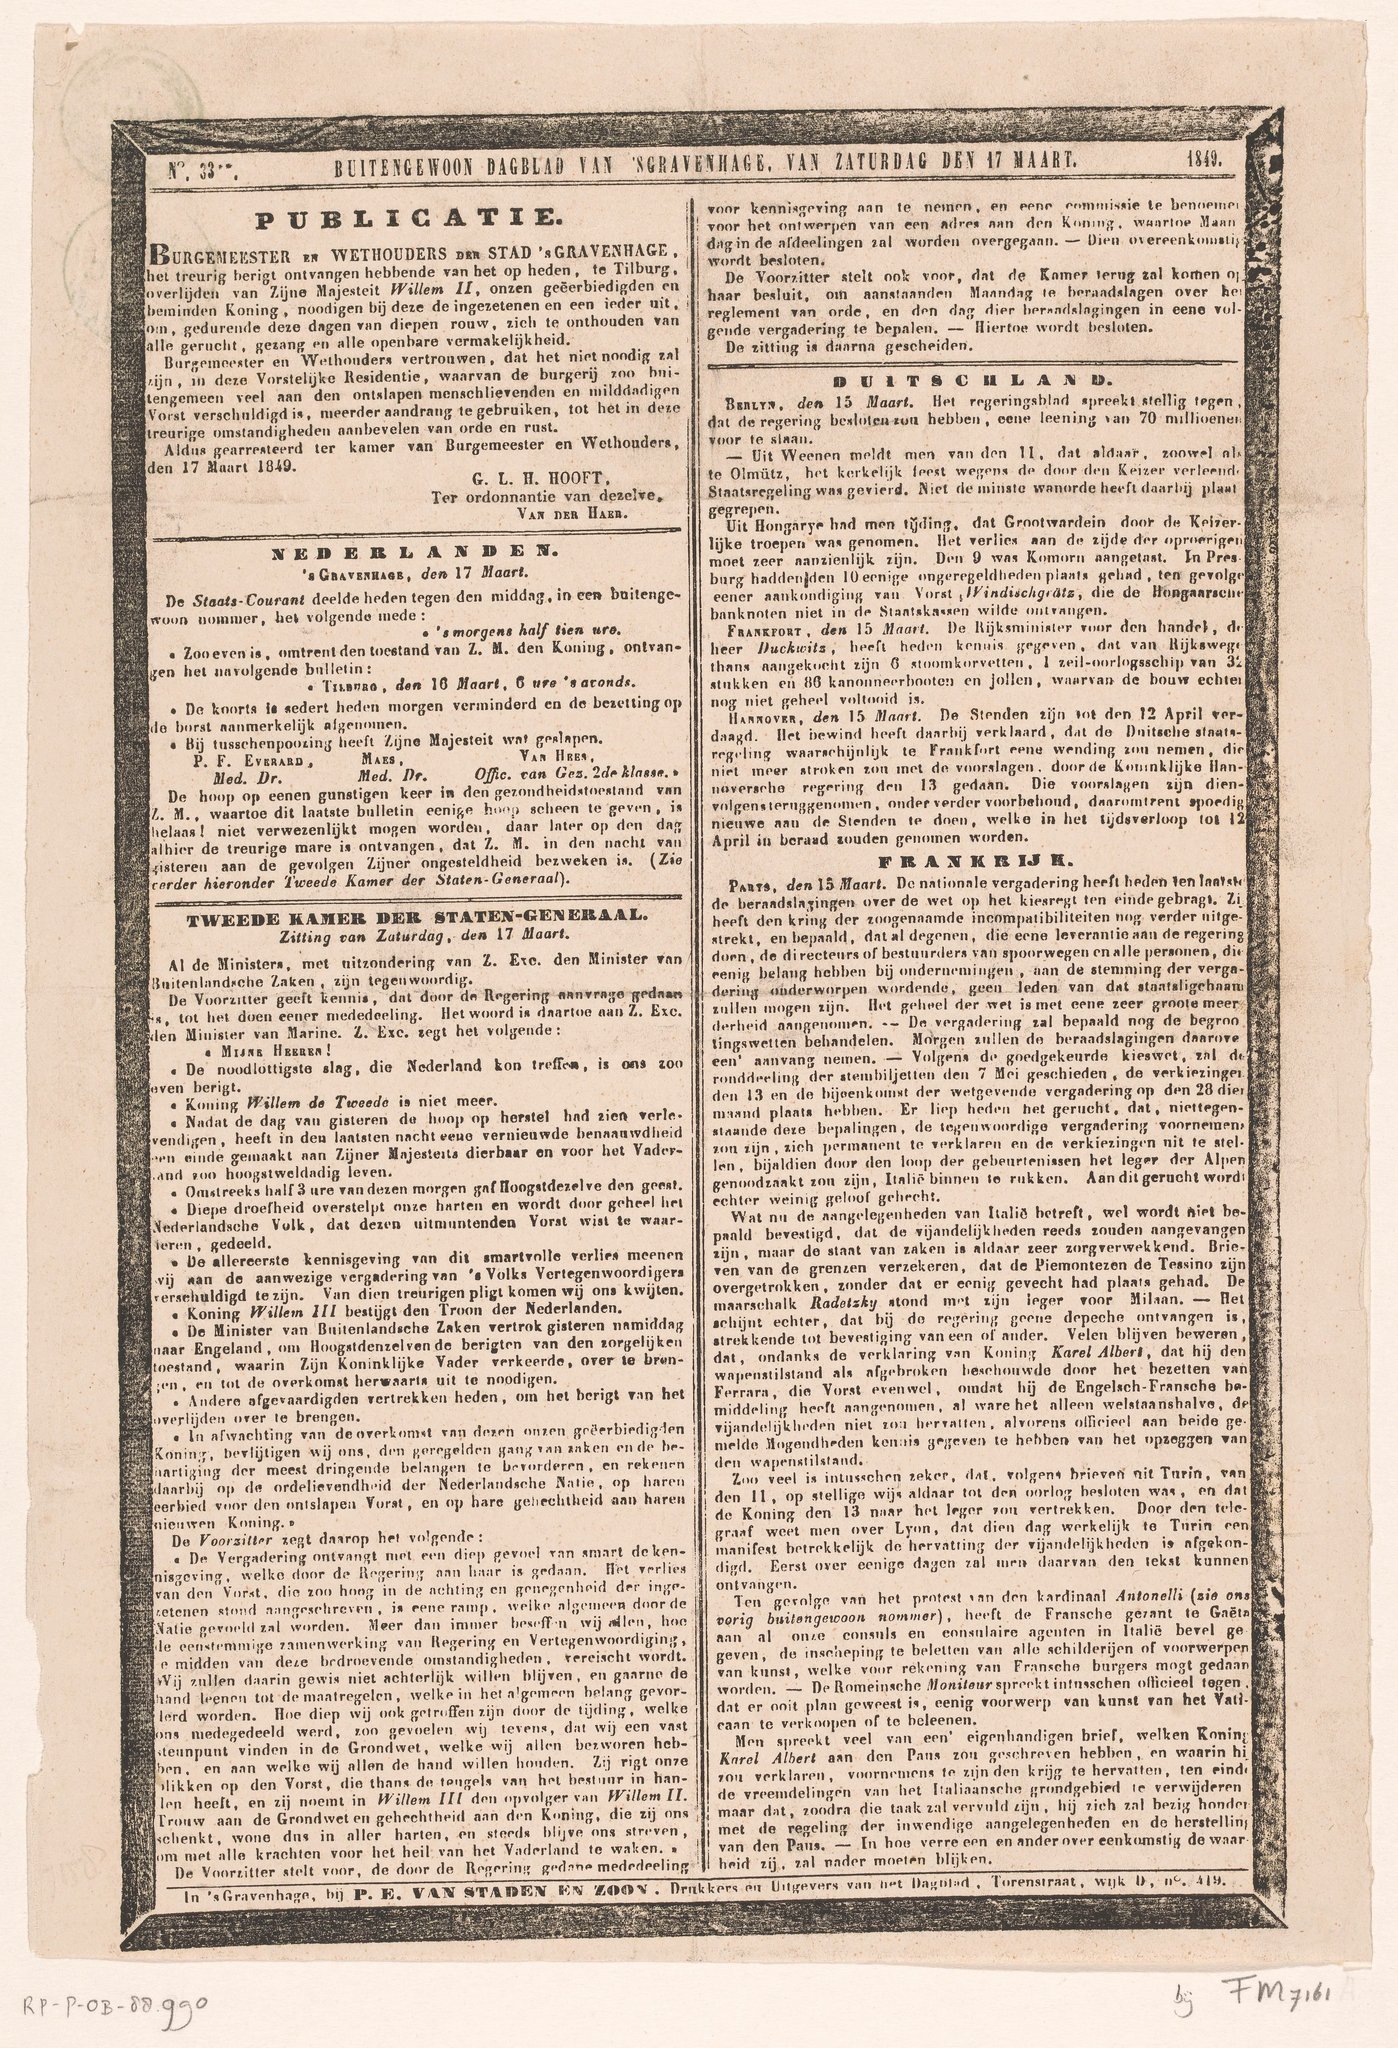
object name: newspaper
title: Buitengewoon Dagblad van 'sGravenhage, van Zaturdag den 17 Maart. No. 33**. 1849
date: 1849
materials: paper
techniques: letterpress printing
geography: the hague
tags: william ii of the netherlands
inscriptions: collector's mark: Lugt 2228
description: Exemplaar van het Buitengewoon Dagblad van 's-Gravenhage van 17 maart 1849, met het nieuws van het overlijden van koning Willem II. Blad met zwarte rouwranden bedrukt op één zijde.